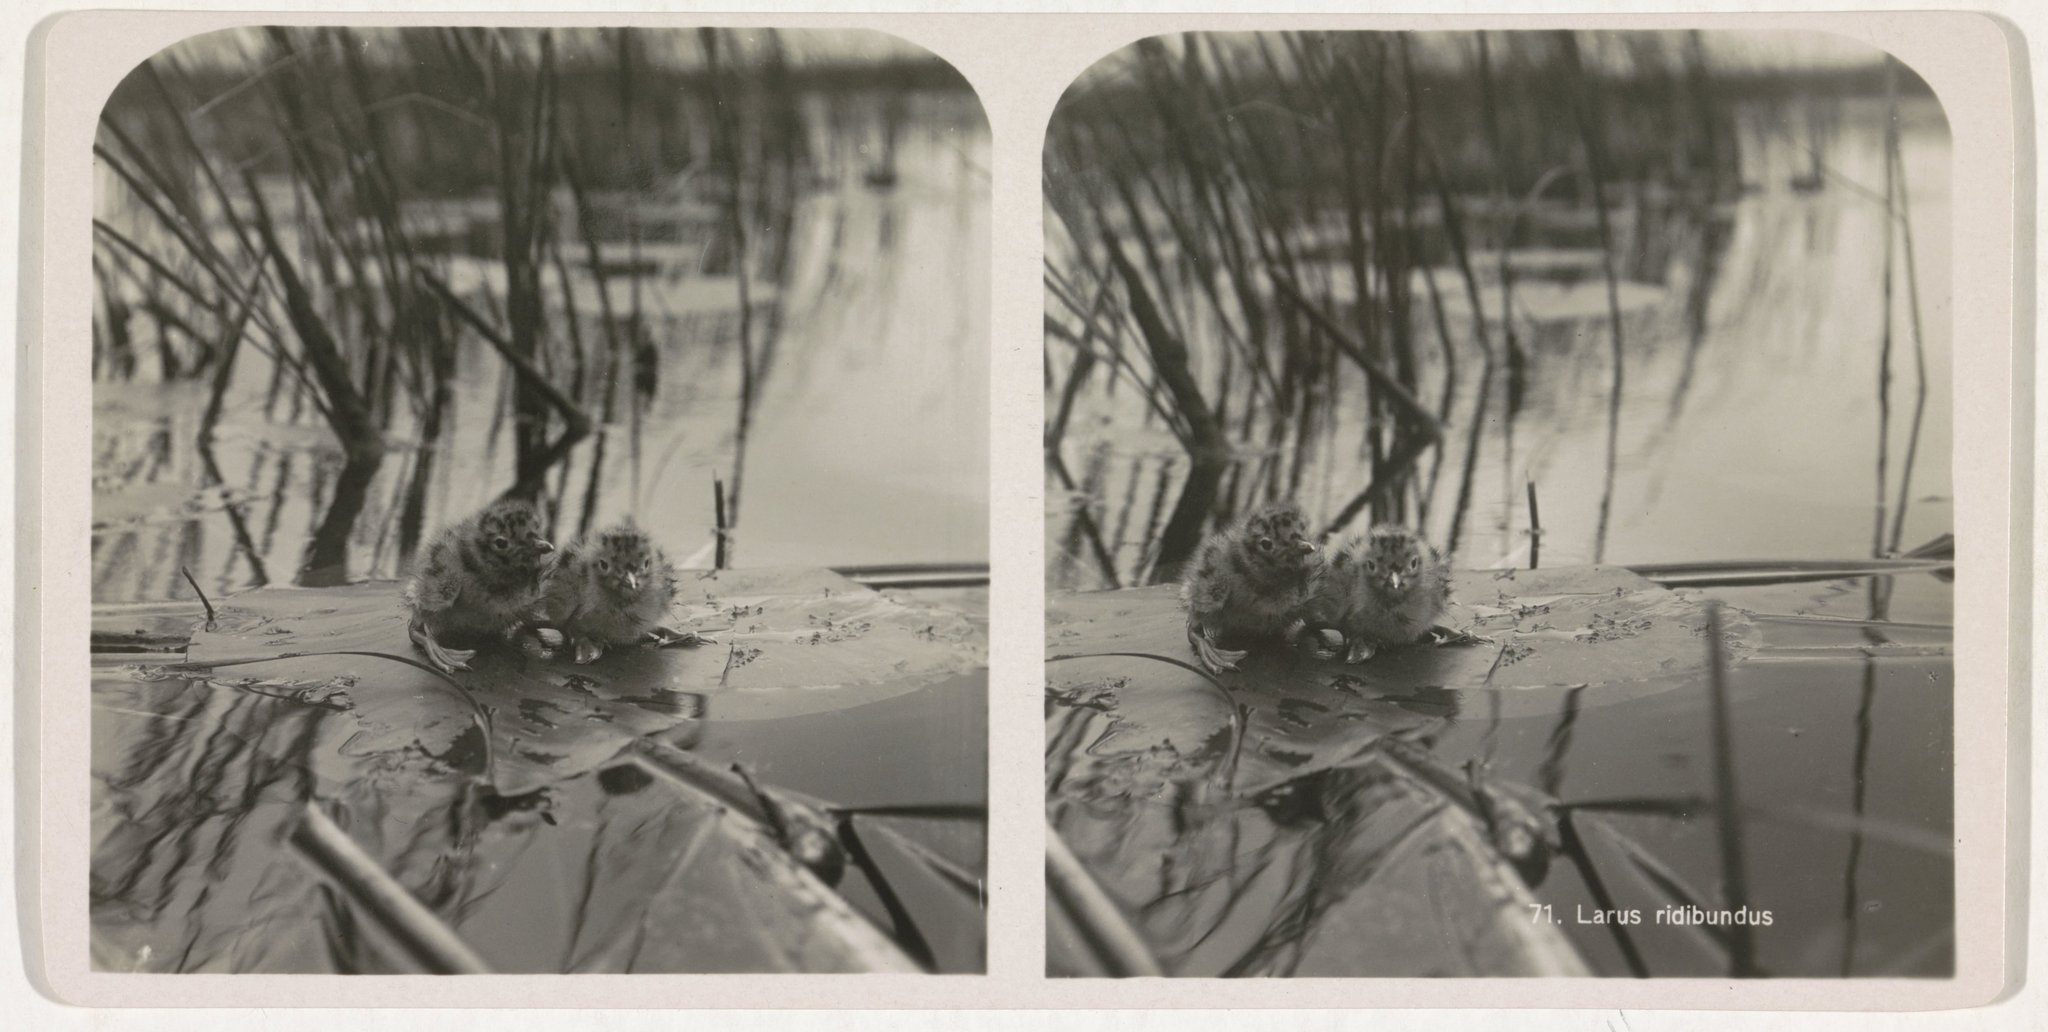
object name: stereograph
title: 71. Larus ridibundus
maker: adolphe burdet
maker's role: fotograaf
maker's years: 1860-1940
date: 1870-1940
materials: photographic support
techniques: gelatin silver print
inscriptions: label: ‘Meeuw’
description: De foto maakt deel uit van een serie van 12 stereofoto's, bewaard in het originele mapje. De foto's tonen zeevogels in natuurgebied De Bol op Texel.